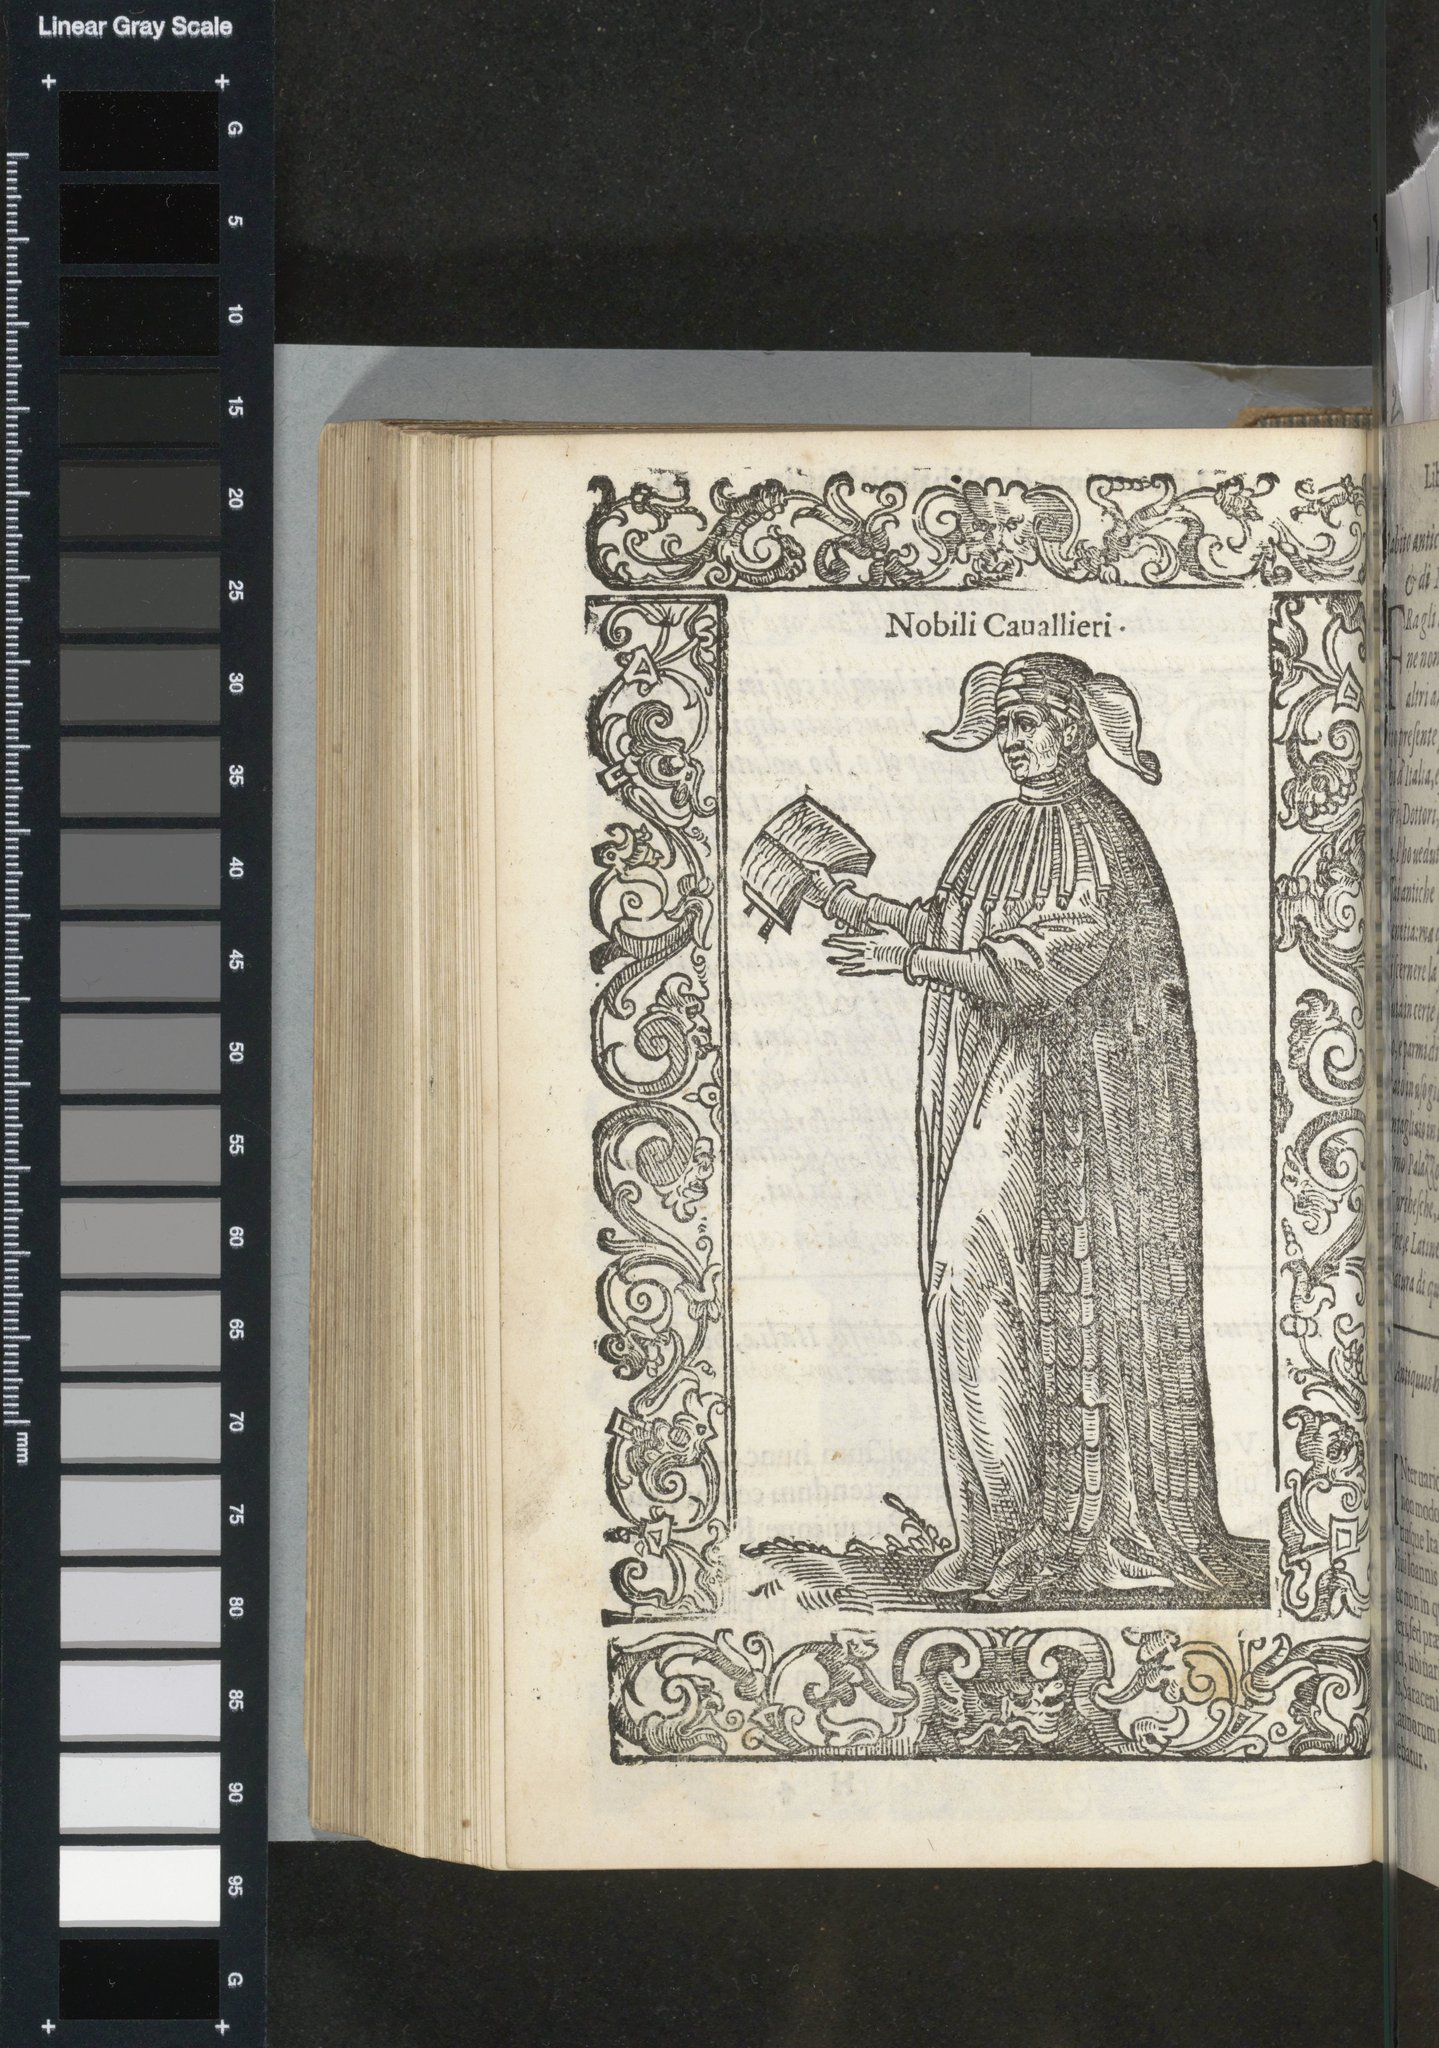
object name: costume print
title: Habiti antichi, et moderni di tutto il mondo..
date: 1598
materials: paper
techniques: woodcut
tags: fashion plates